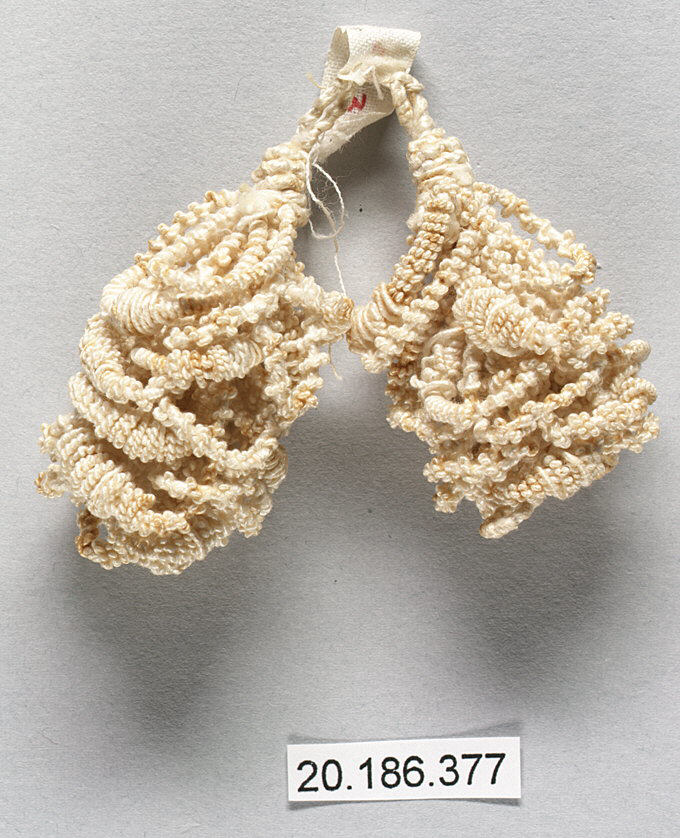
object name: tassel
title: Pair of tassels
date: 1634-1666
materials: linen